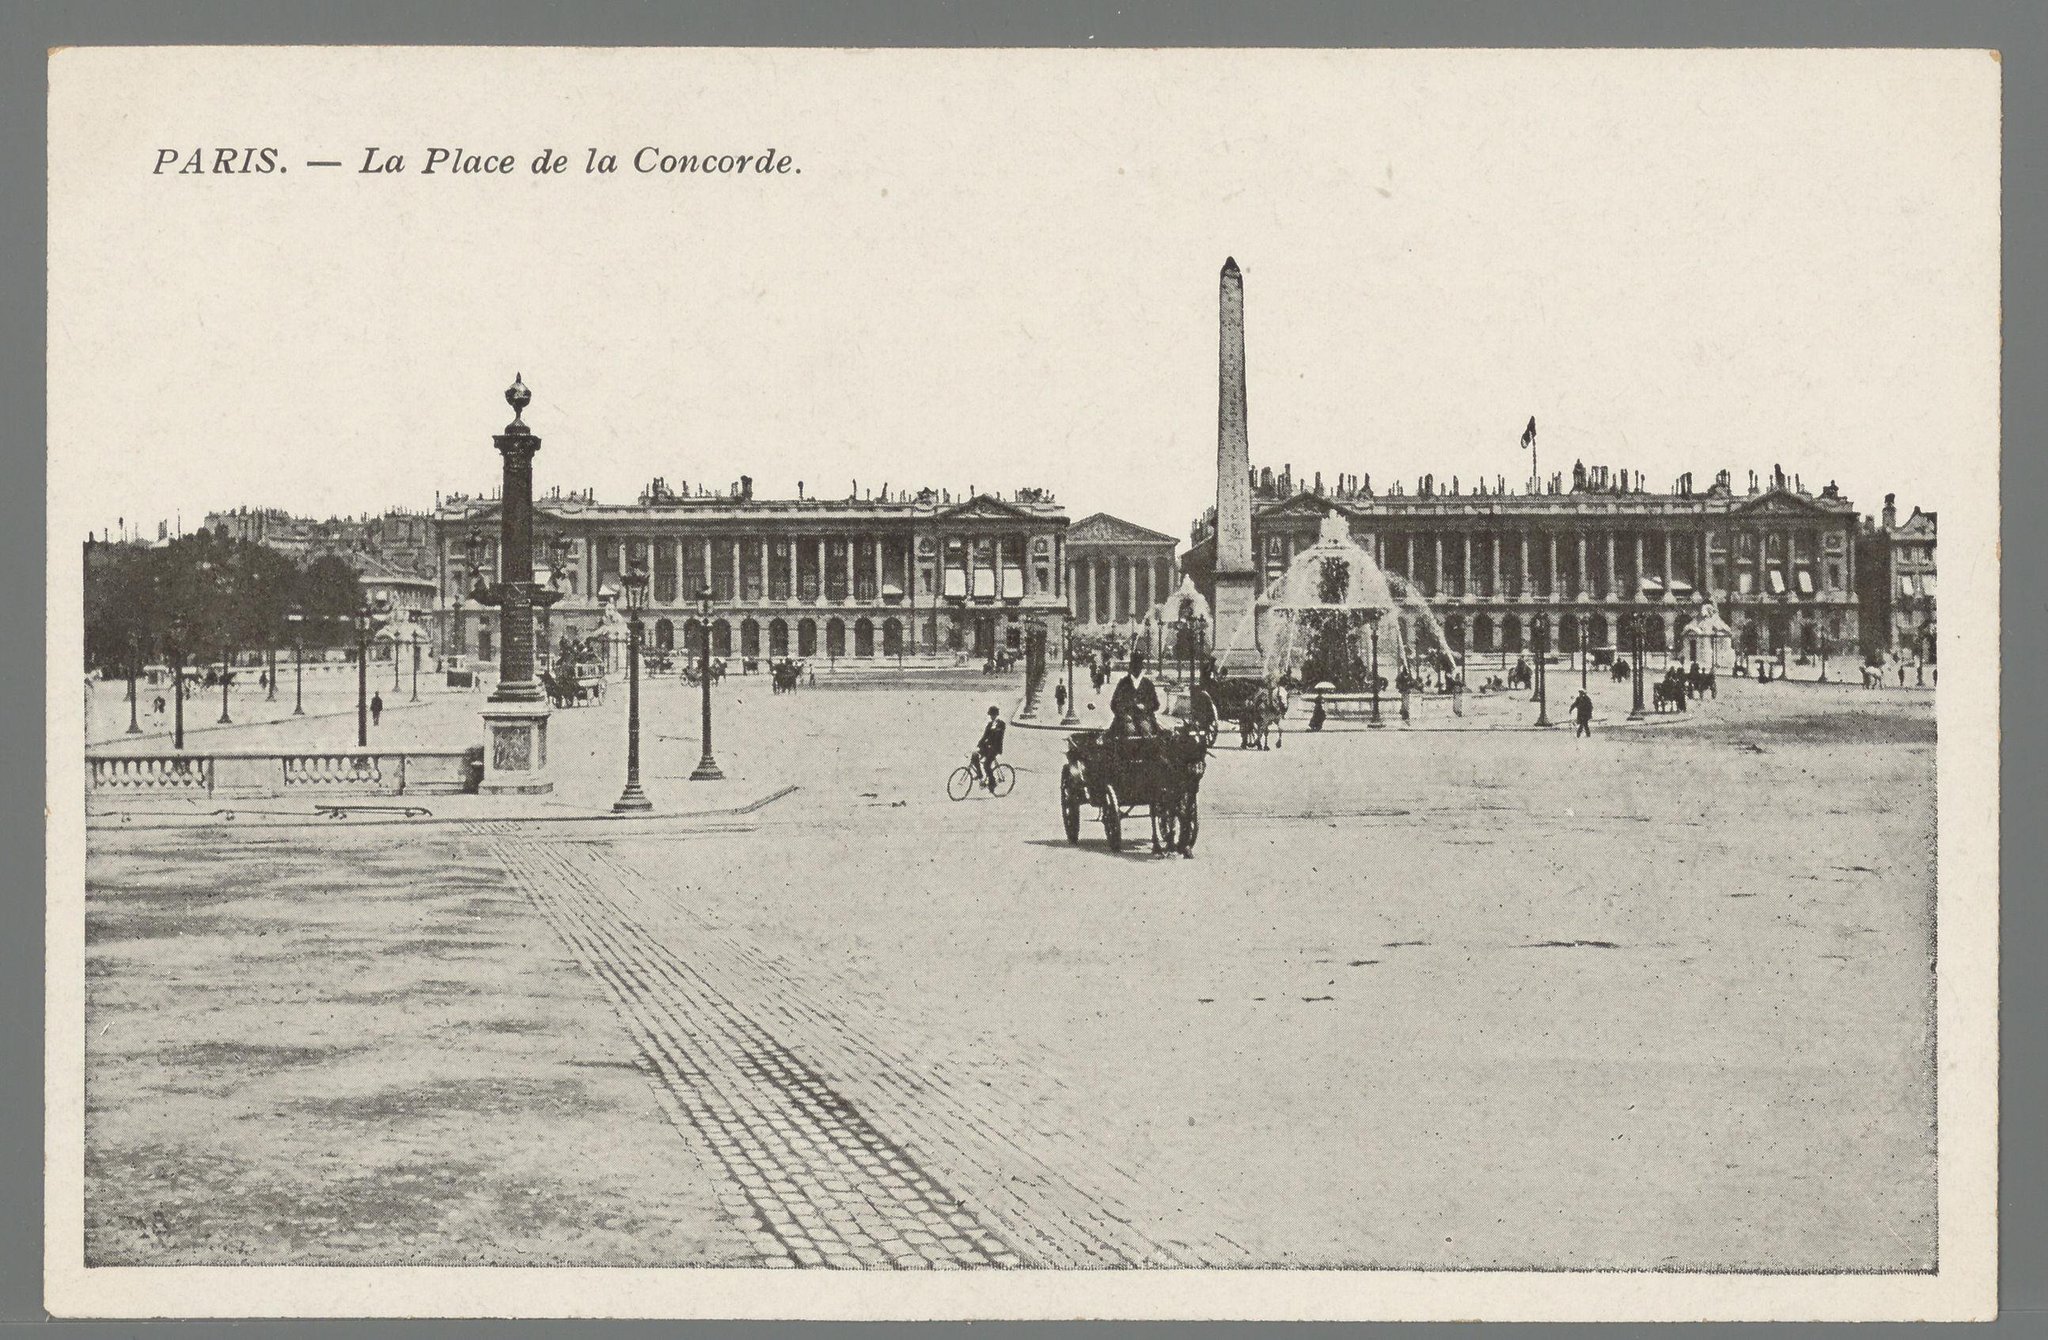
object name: ansichtkaart, prentbriefkaart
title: Paris. La Place de la Concorde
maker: Anonymous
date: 1904-1906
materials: cardboard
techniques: autotype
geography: paris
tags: four-wheeled, animal-drawn vehicle, e.g.: cab, carriage, coach, monument, statue, square, place, circus, etc. (+ city(-scape) with figures, staffage)